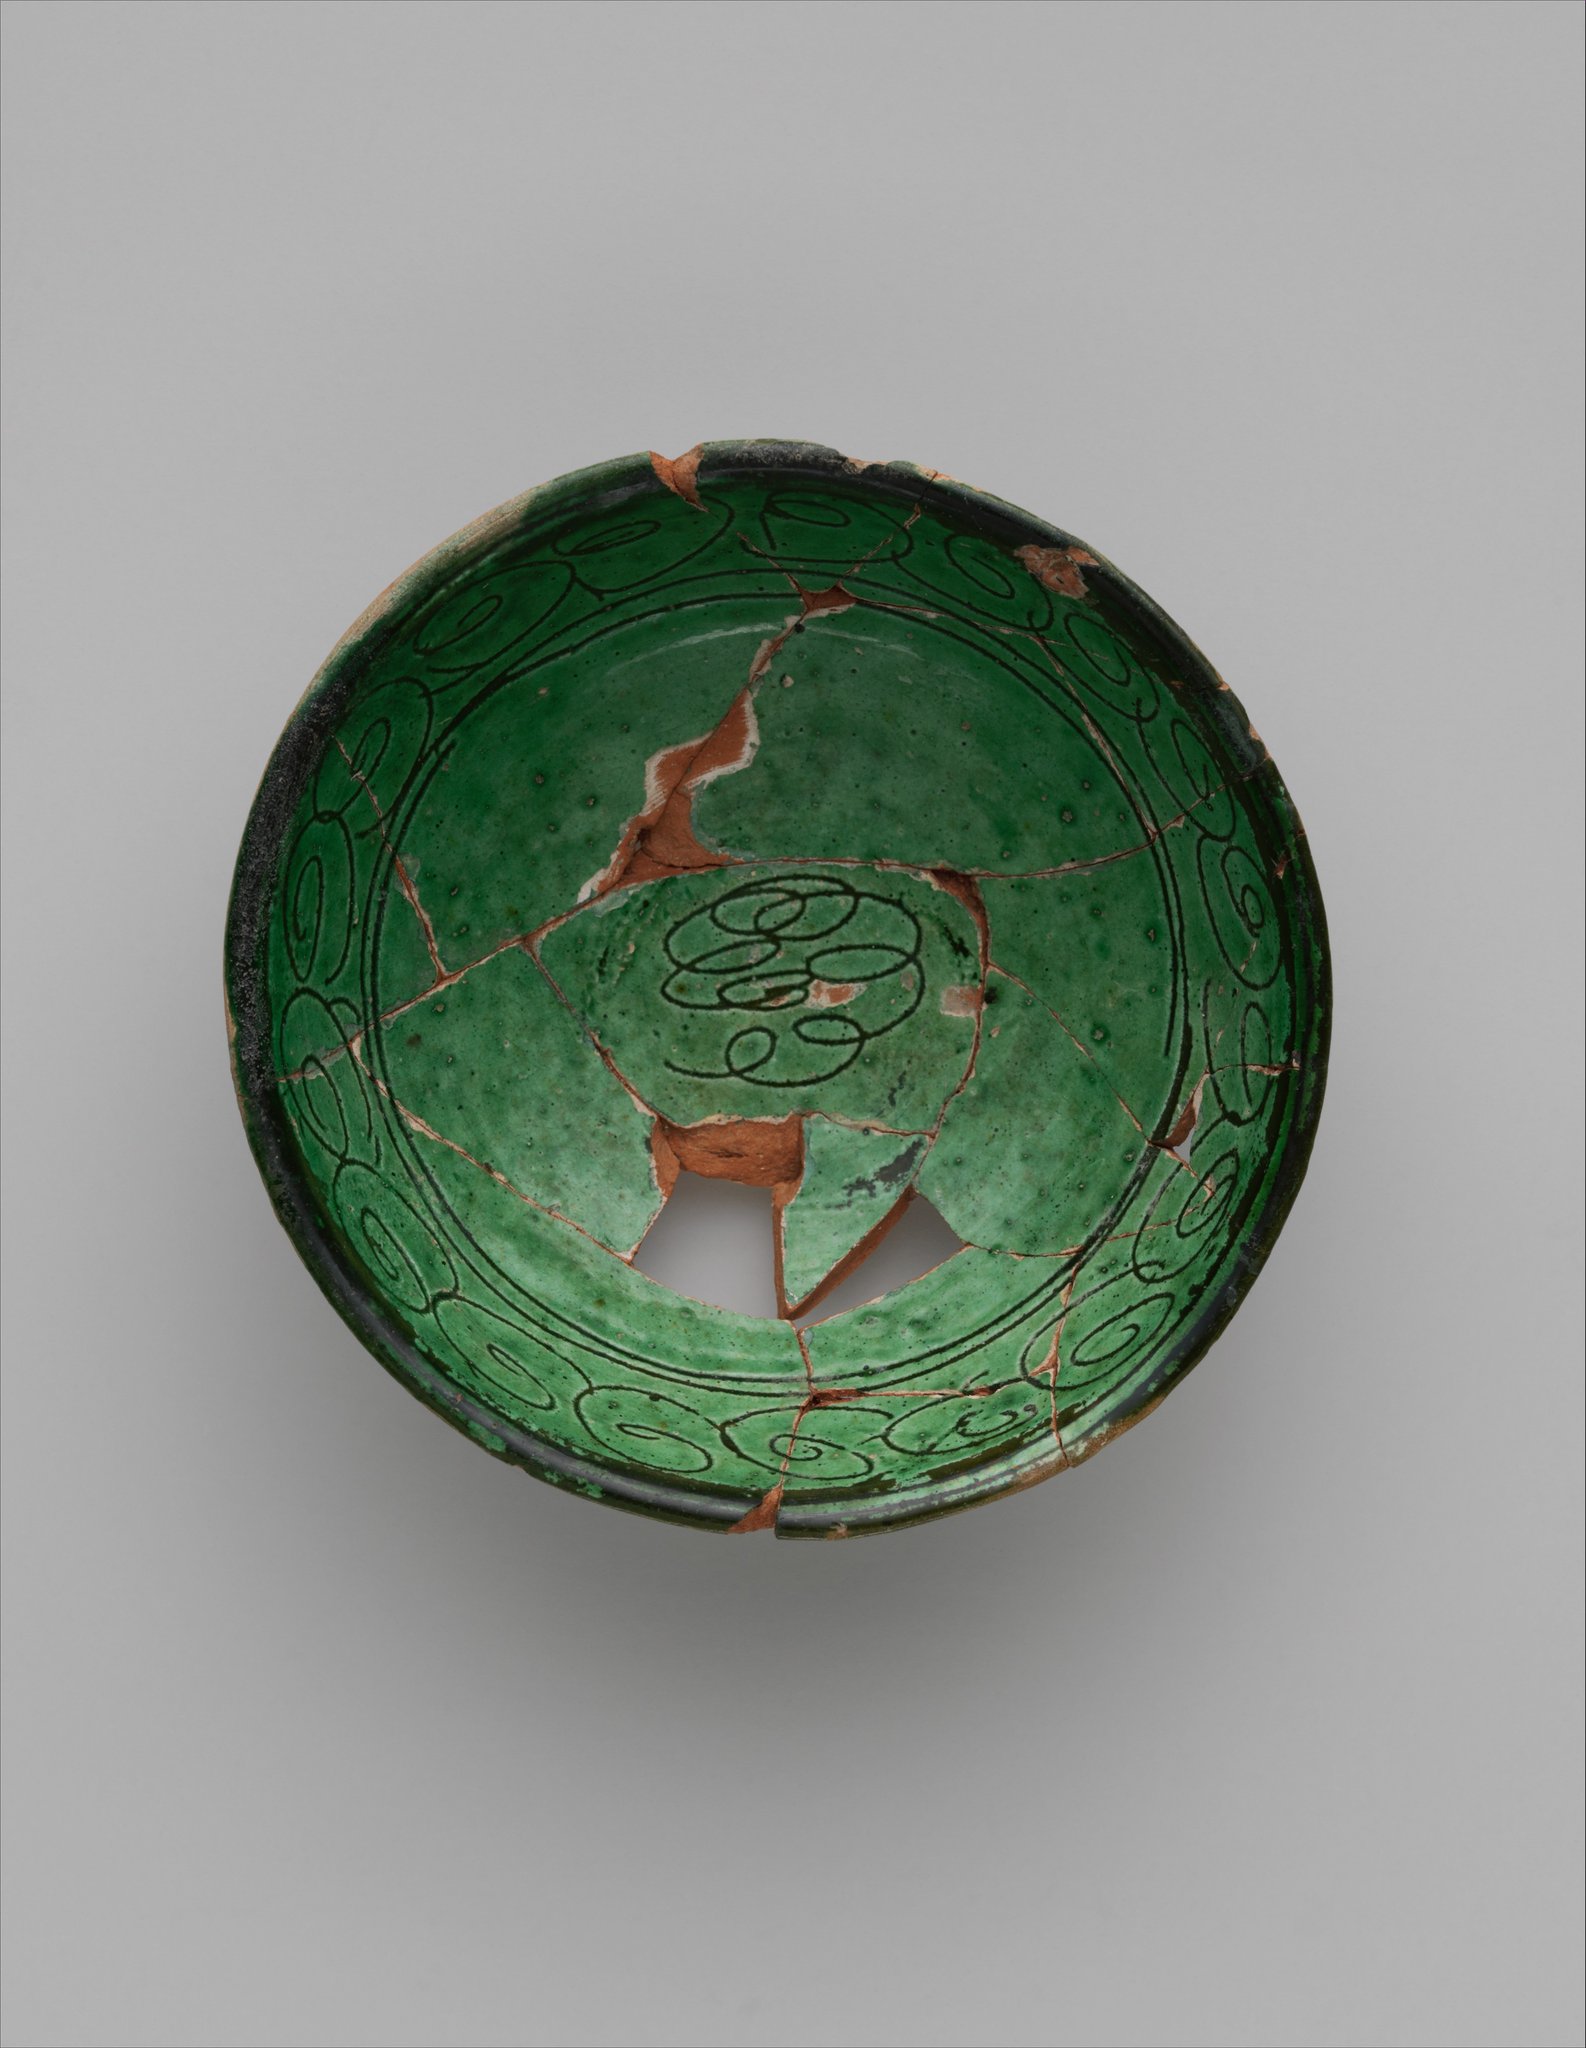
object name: bowl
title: Green Glazed Bowl with Incised Decoration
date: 801-900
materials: earthenware, glaze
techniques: incising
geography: iran